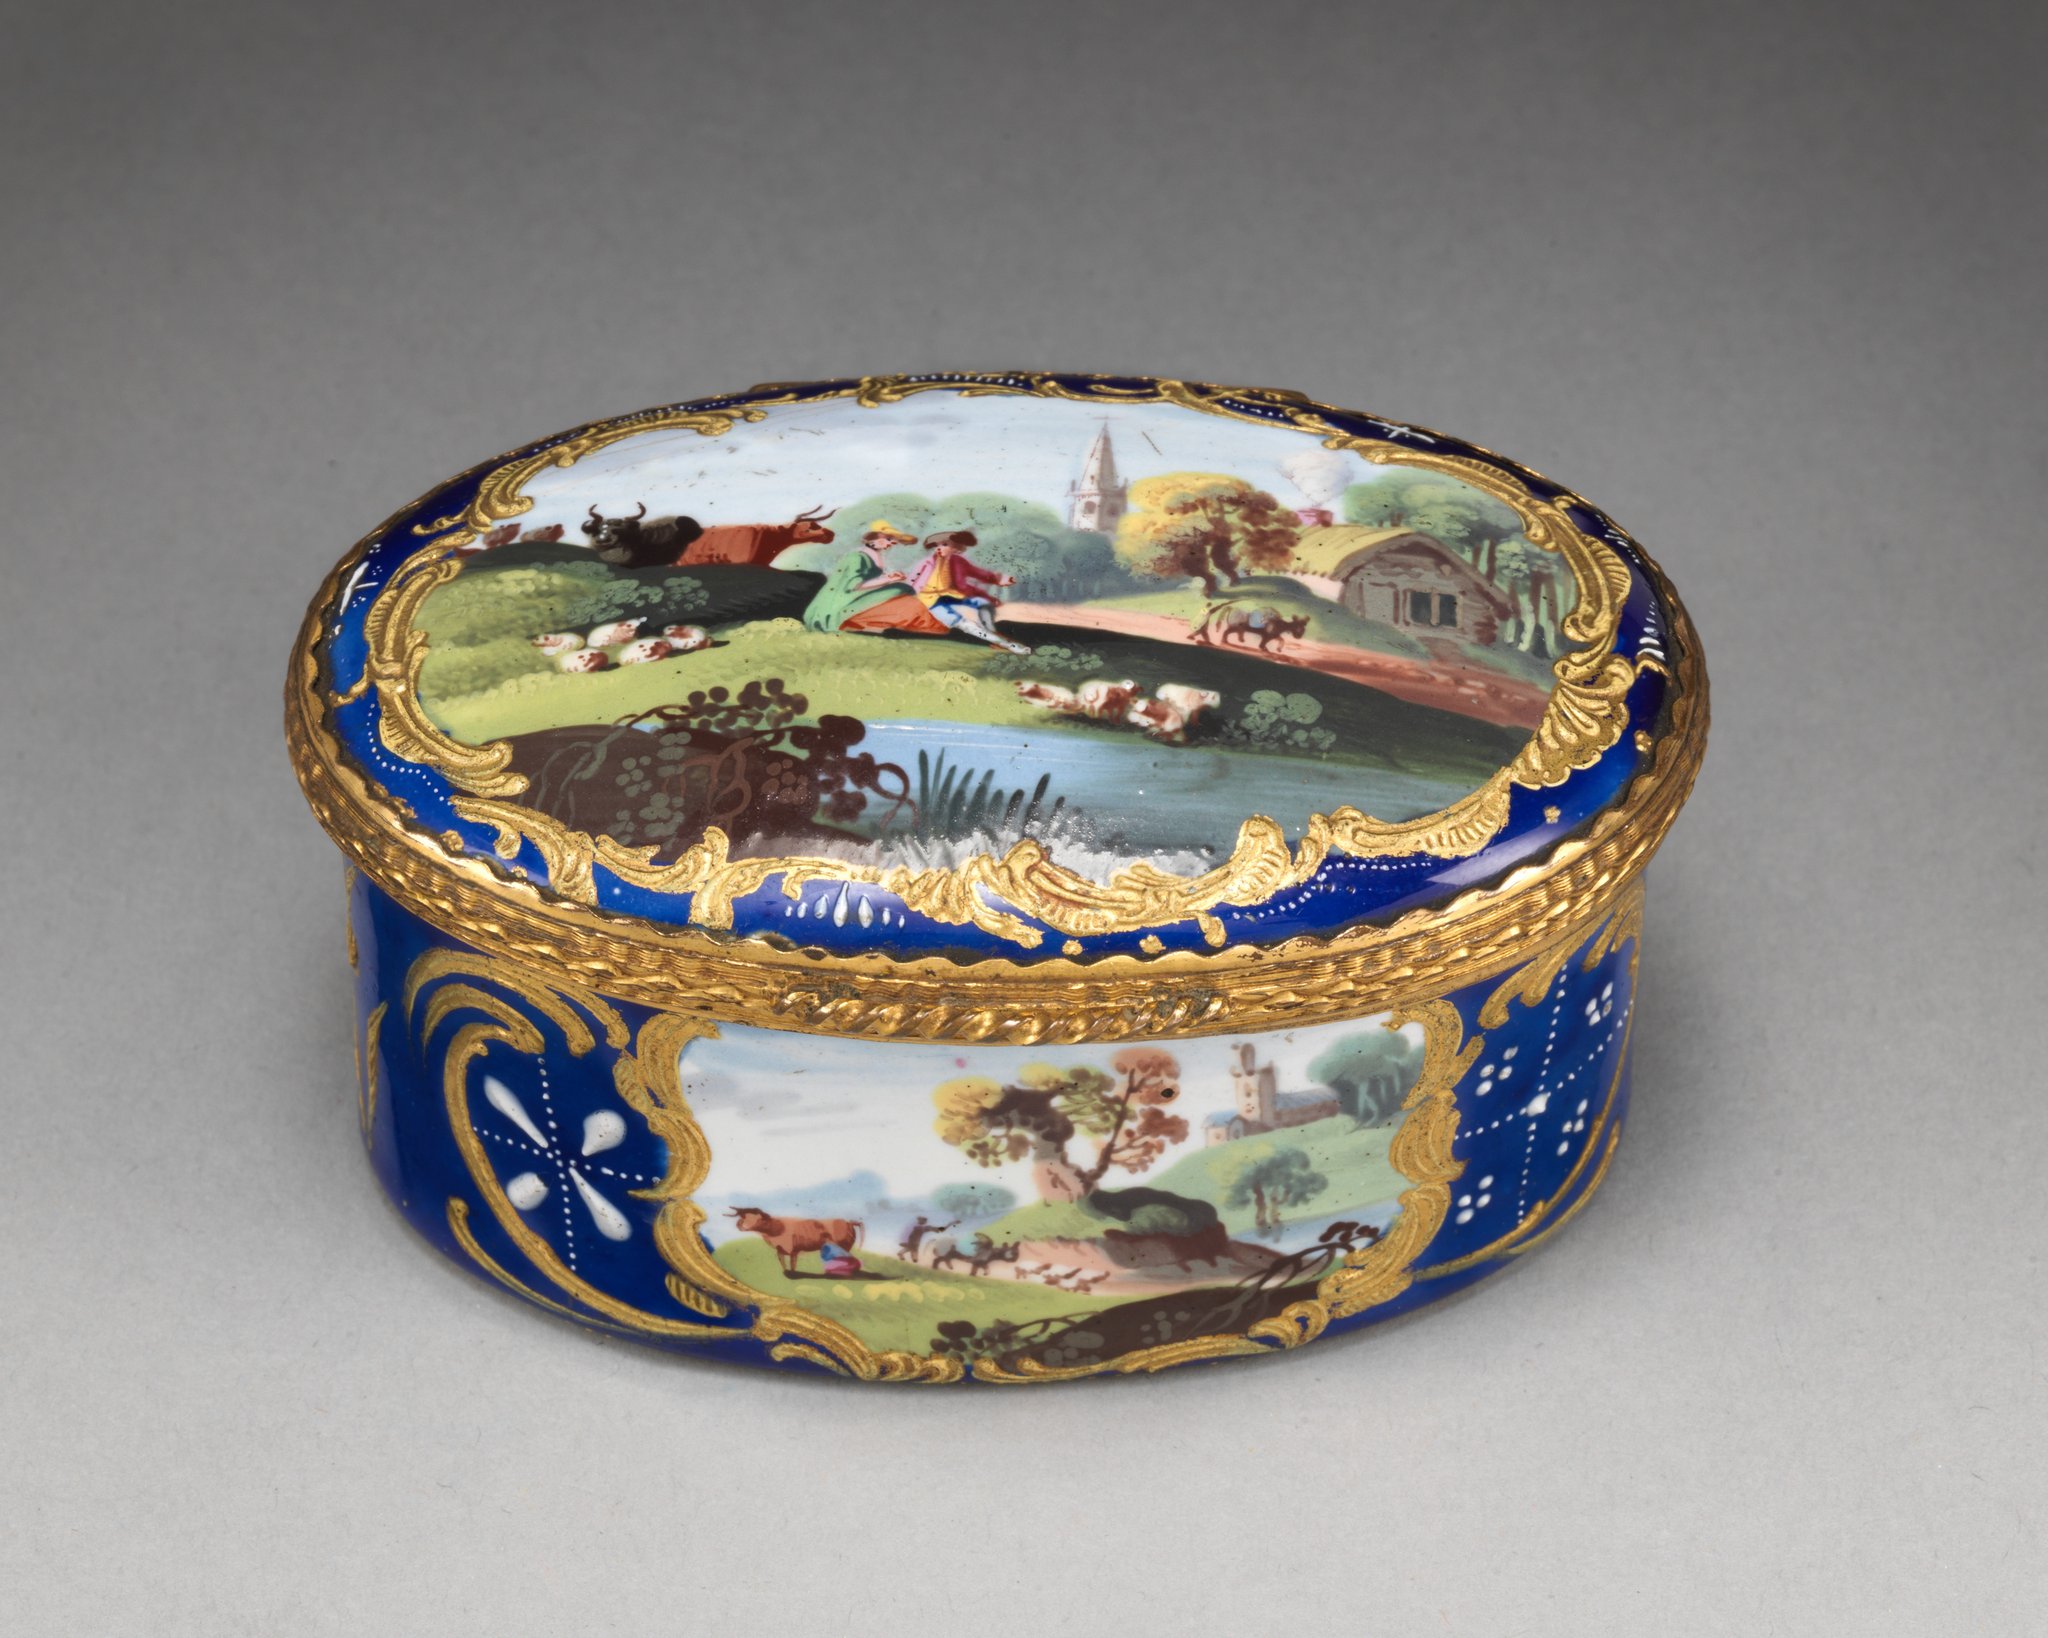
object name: snuffbox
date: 1770-1780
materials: copper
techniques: enamel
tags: animals,men,women,trees